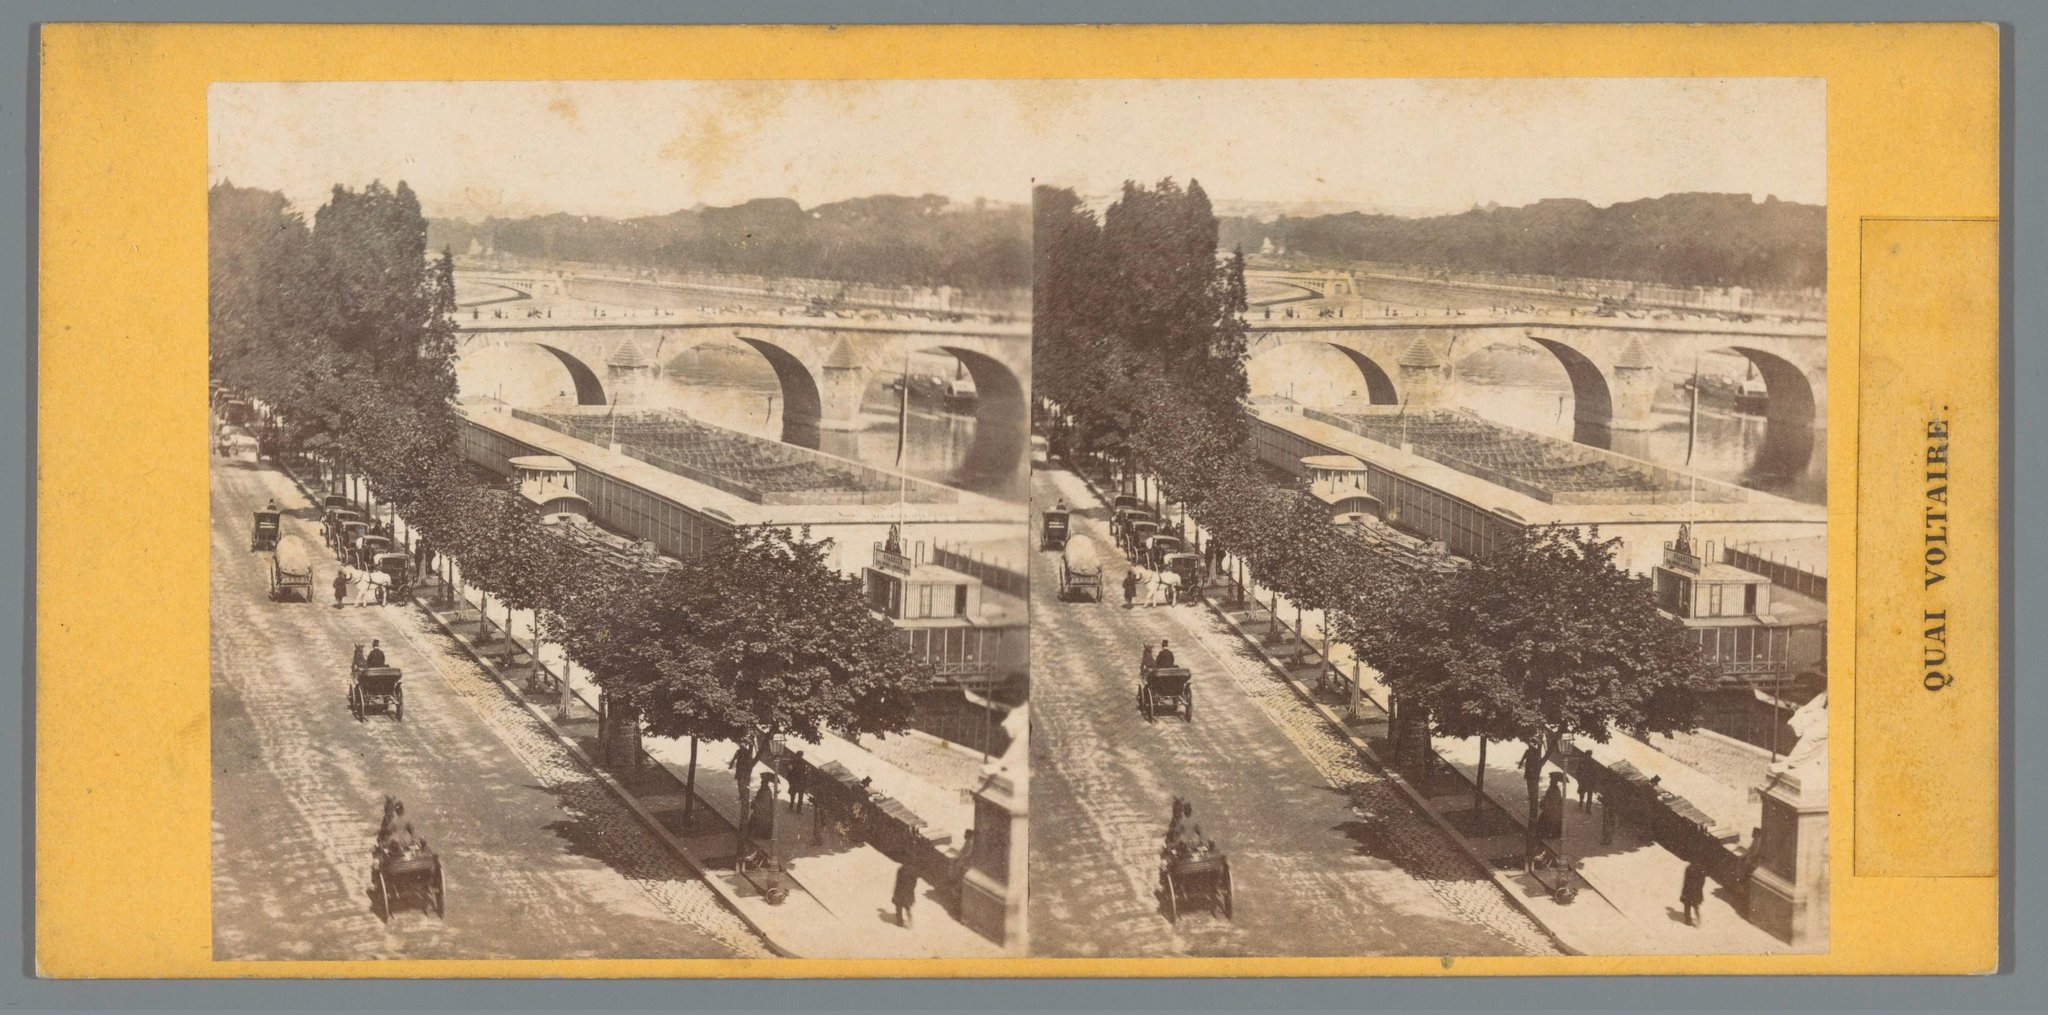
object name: stereograph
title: Quai Voltaire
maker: Anonymous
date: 1860-1865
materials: cardboard, photographic support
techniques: albumen print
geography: paris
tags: two-wheeled vehicle drawn by one animal, quay